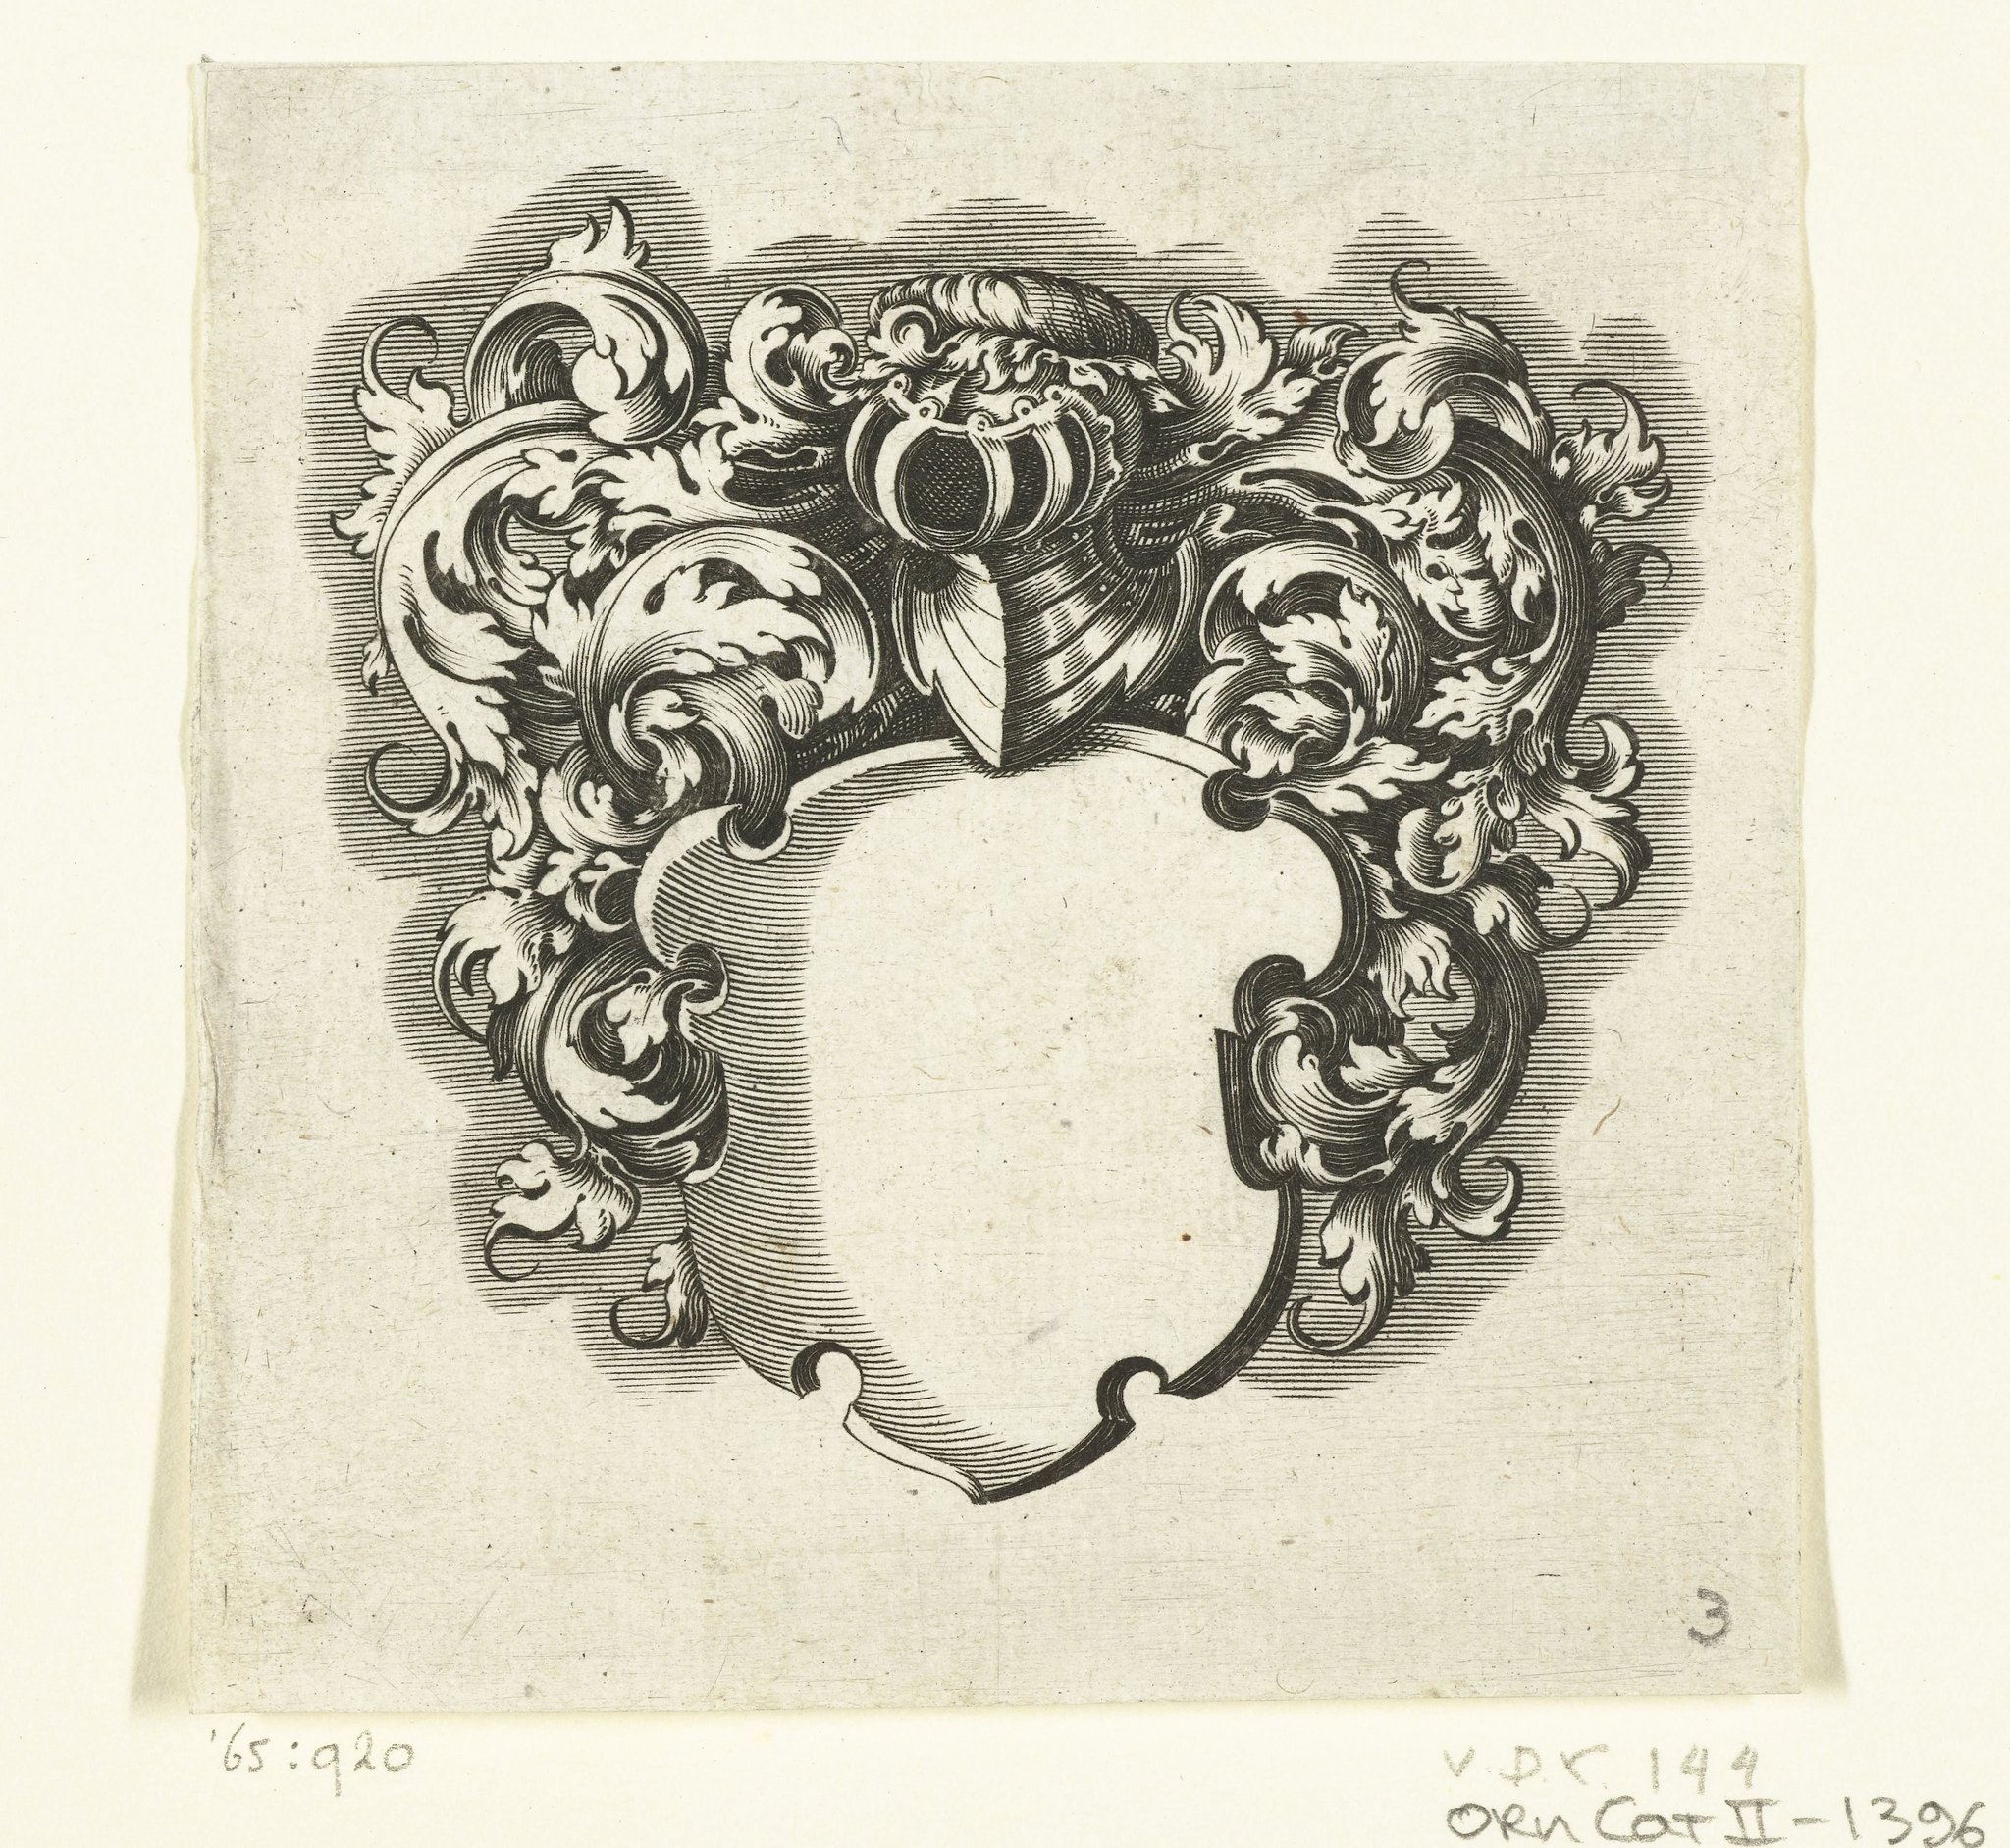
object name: print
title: Wapenschilden met lege velden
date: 1627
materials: paper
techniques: engraving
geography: amsterdam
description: Verkleinde tegenzijdige kopie van het wapenschild, zonder de vleugel op de helm en met een leeg schild.